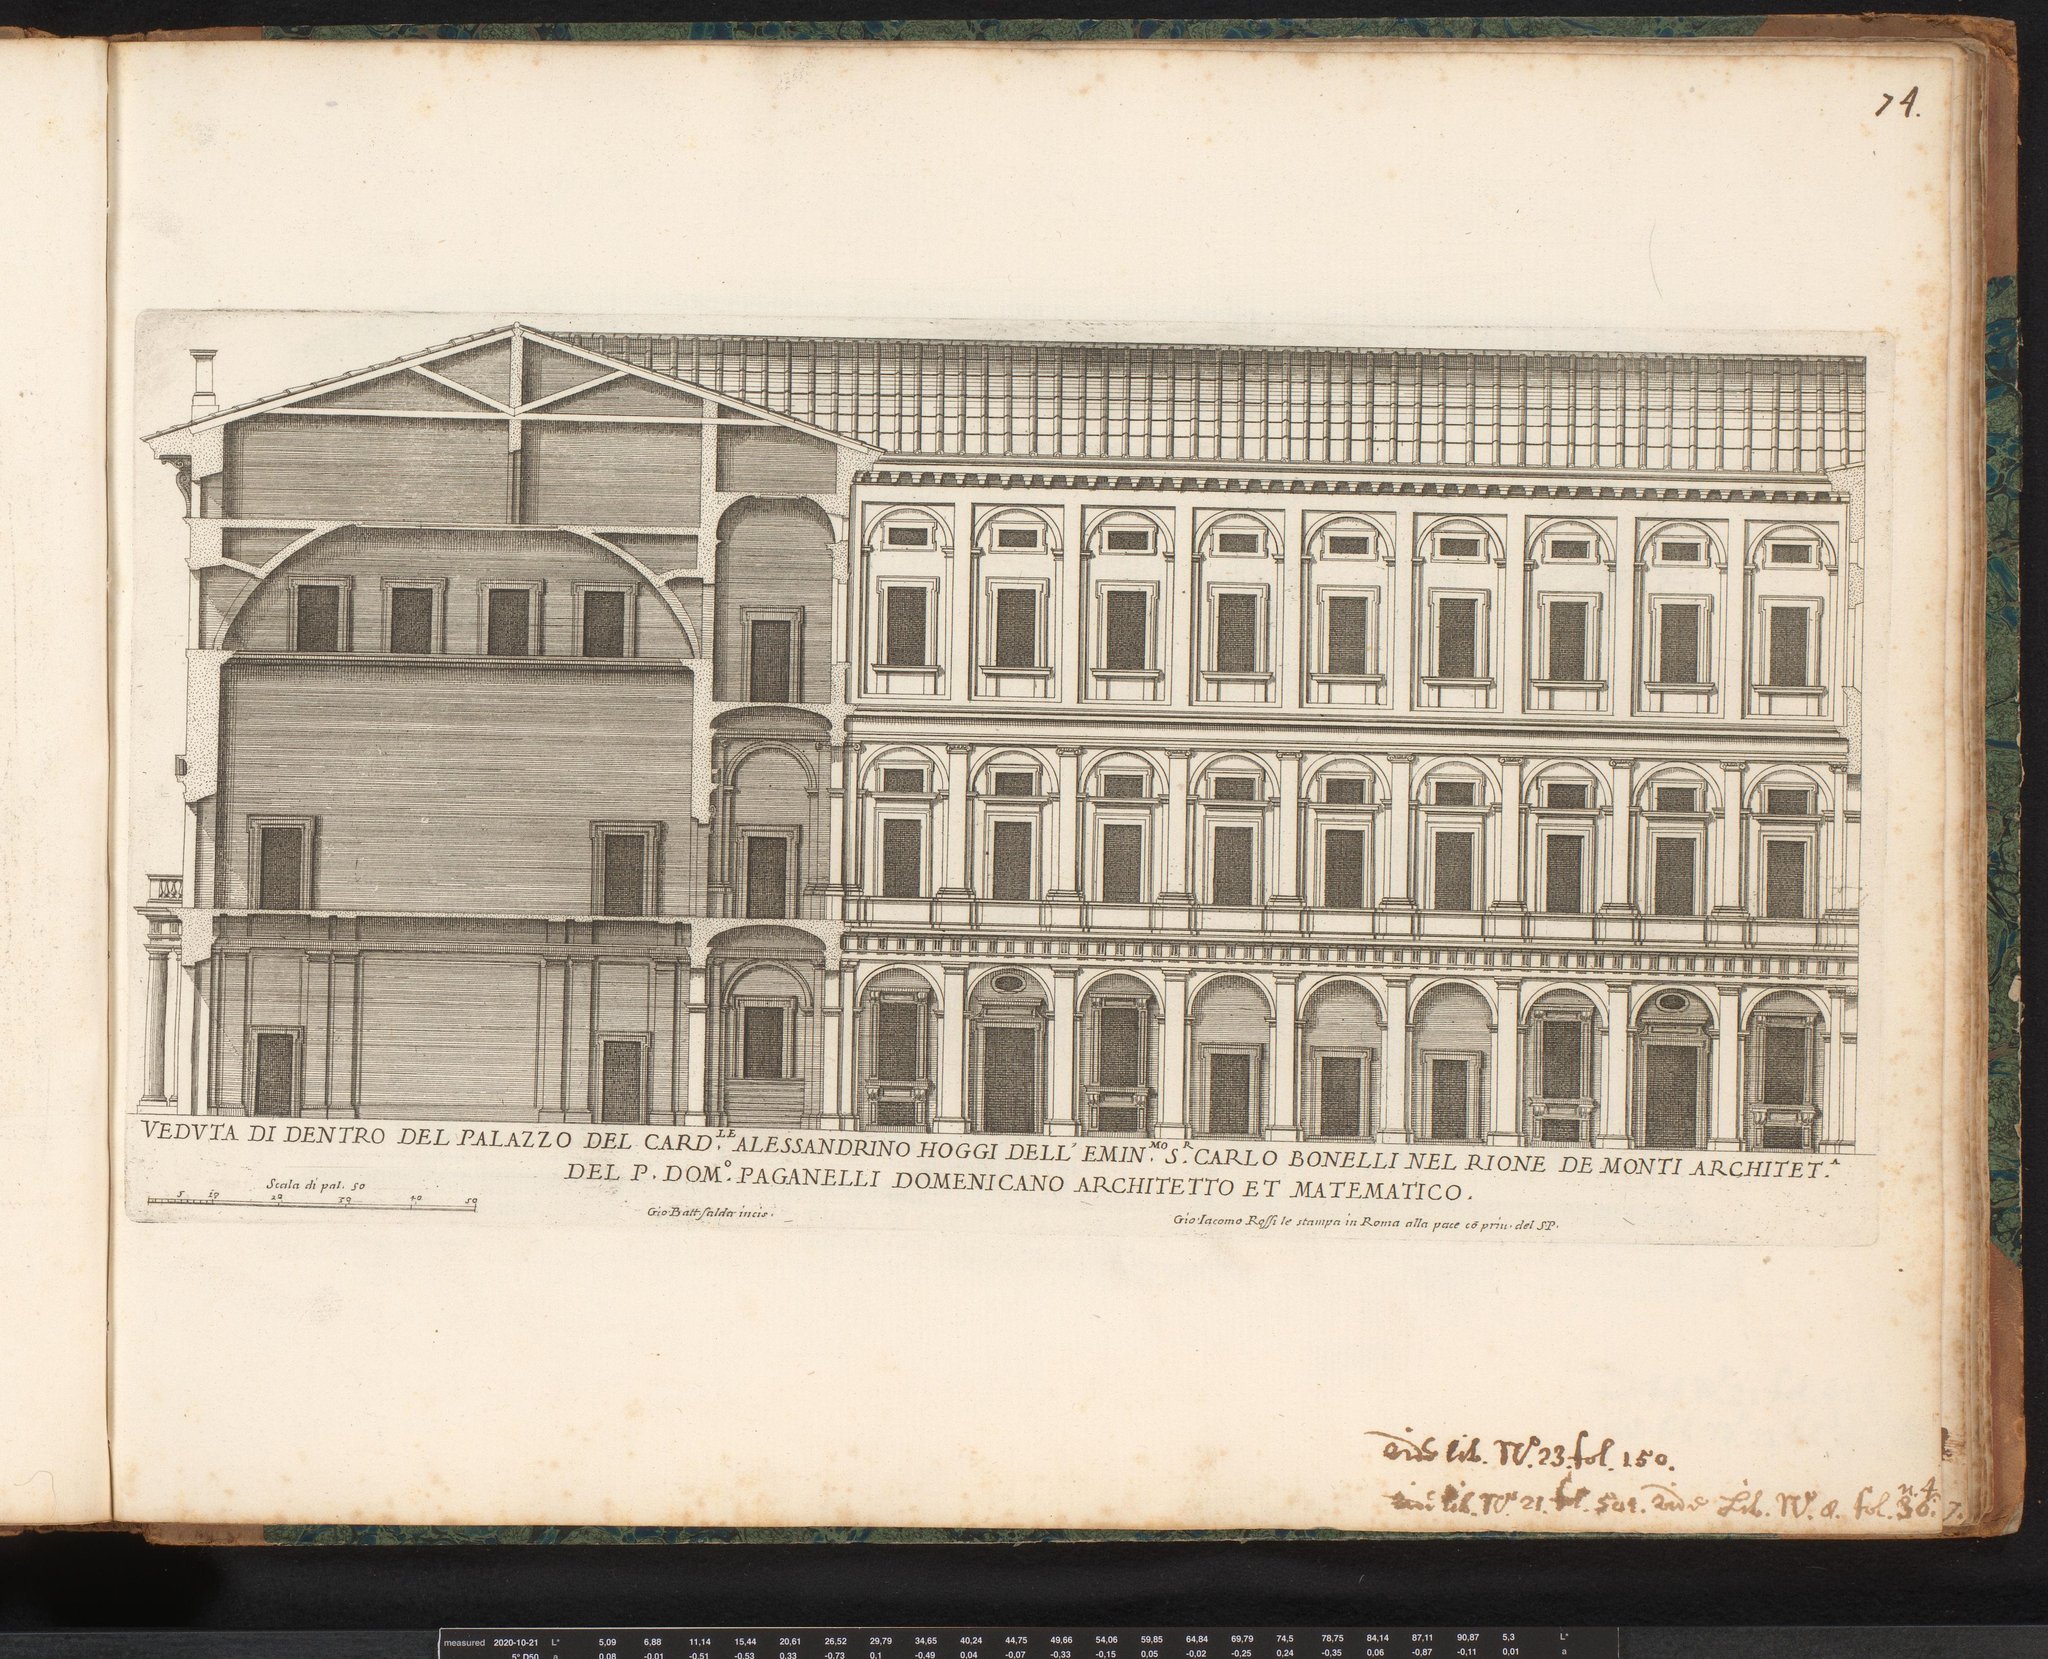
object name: print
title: Palazzi di Roma dei più celebri architett (...)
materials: paper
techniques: etching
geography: vatican city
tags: palace, façade (of house or building), rome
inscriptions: number: ‘74’, inscription: ‘Ende lib. No. 23. fol. 150./ Ende lib. No. 21 fol. 501. ende lib. No. 8. fol. 36. 44.’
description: Deze prent maakt deel uit van de reeks getiteld: Palazzi di Roma. Deze reeks bestaat uit twee boeken. Boek één getiteld: Palazzi di Roma dei più celebri architetti..., bestaat uit 44 prenten die worden toegeschreven aan Giovanni Battista Falda (naam staat enkel op prent 27) en uitgegeven door Giovanni Giacomo de'Rossi. Deze 44 prenten zijn bekend in twee staten (met en zonder nummer). Boek twee getiteld: Nuovi disegni dell'architetture... libro secondo, bevat 66 prenten door Giovanni Battista Falda en Simone Felice. Deze 66 prenten zijn bekend in twee staten (met en zonder nummer).